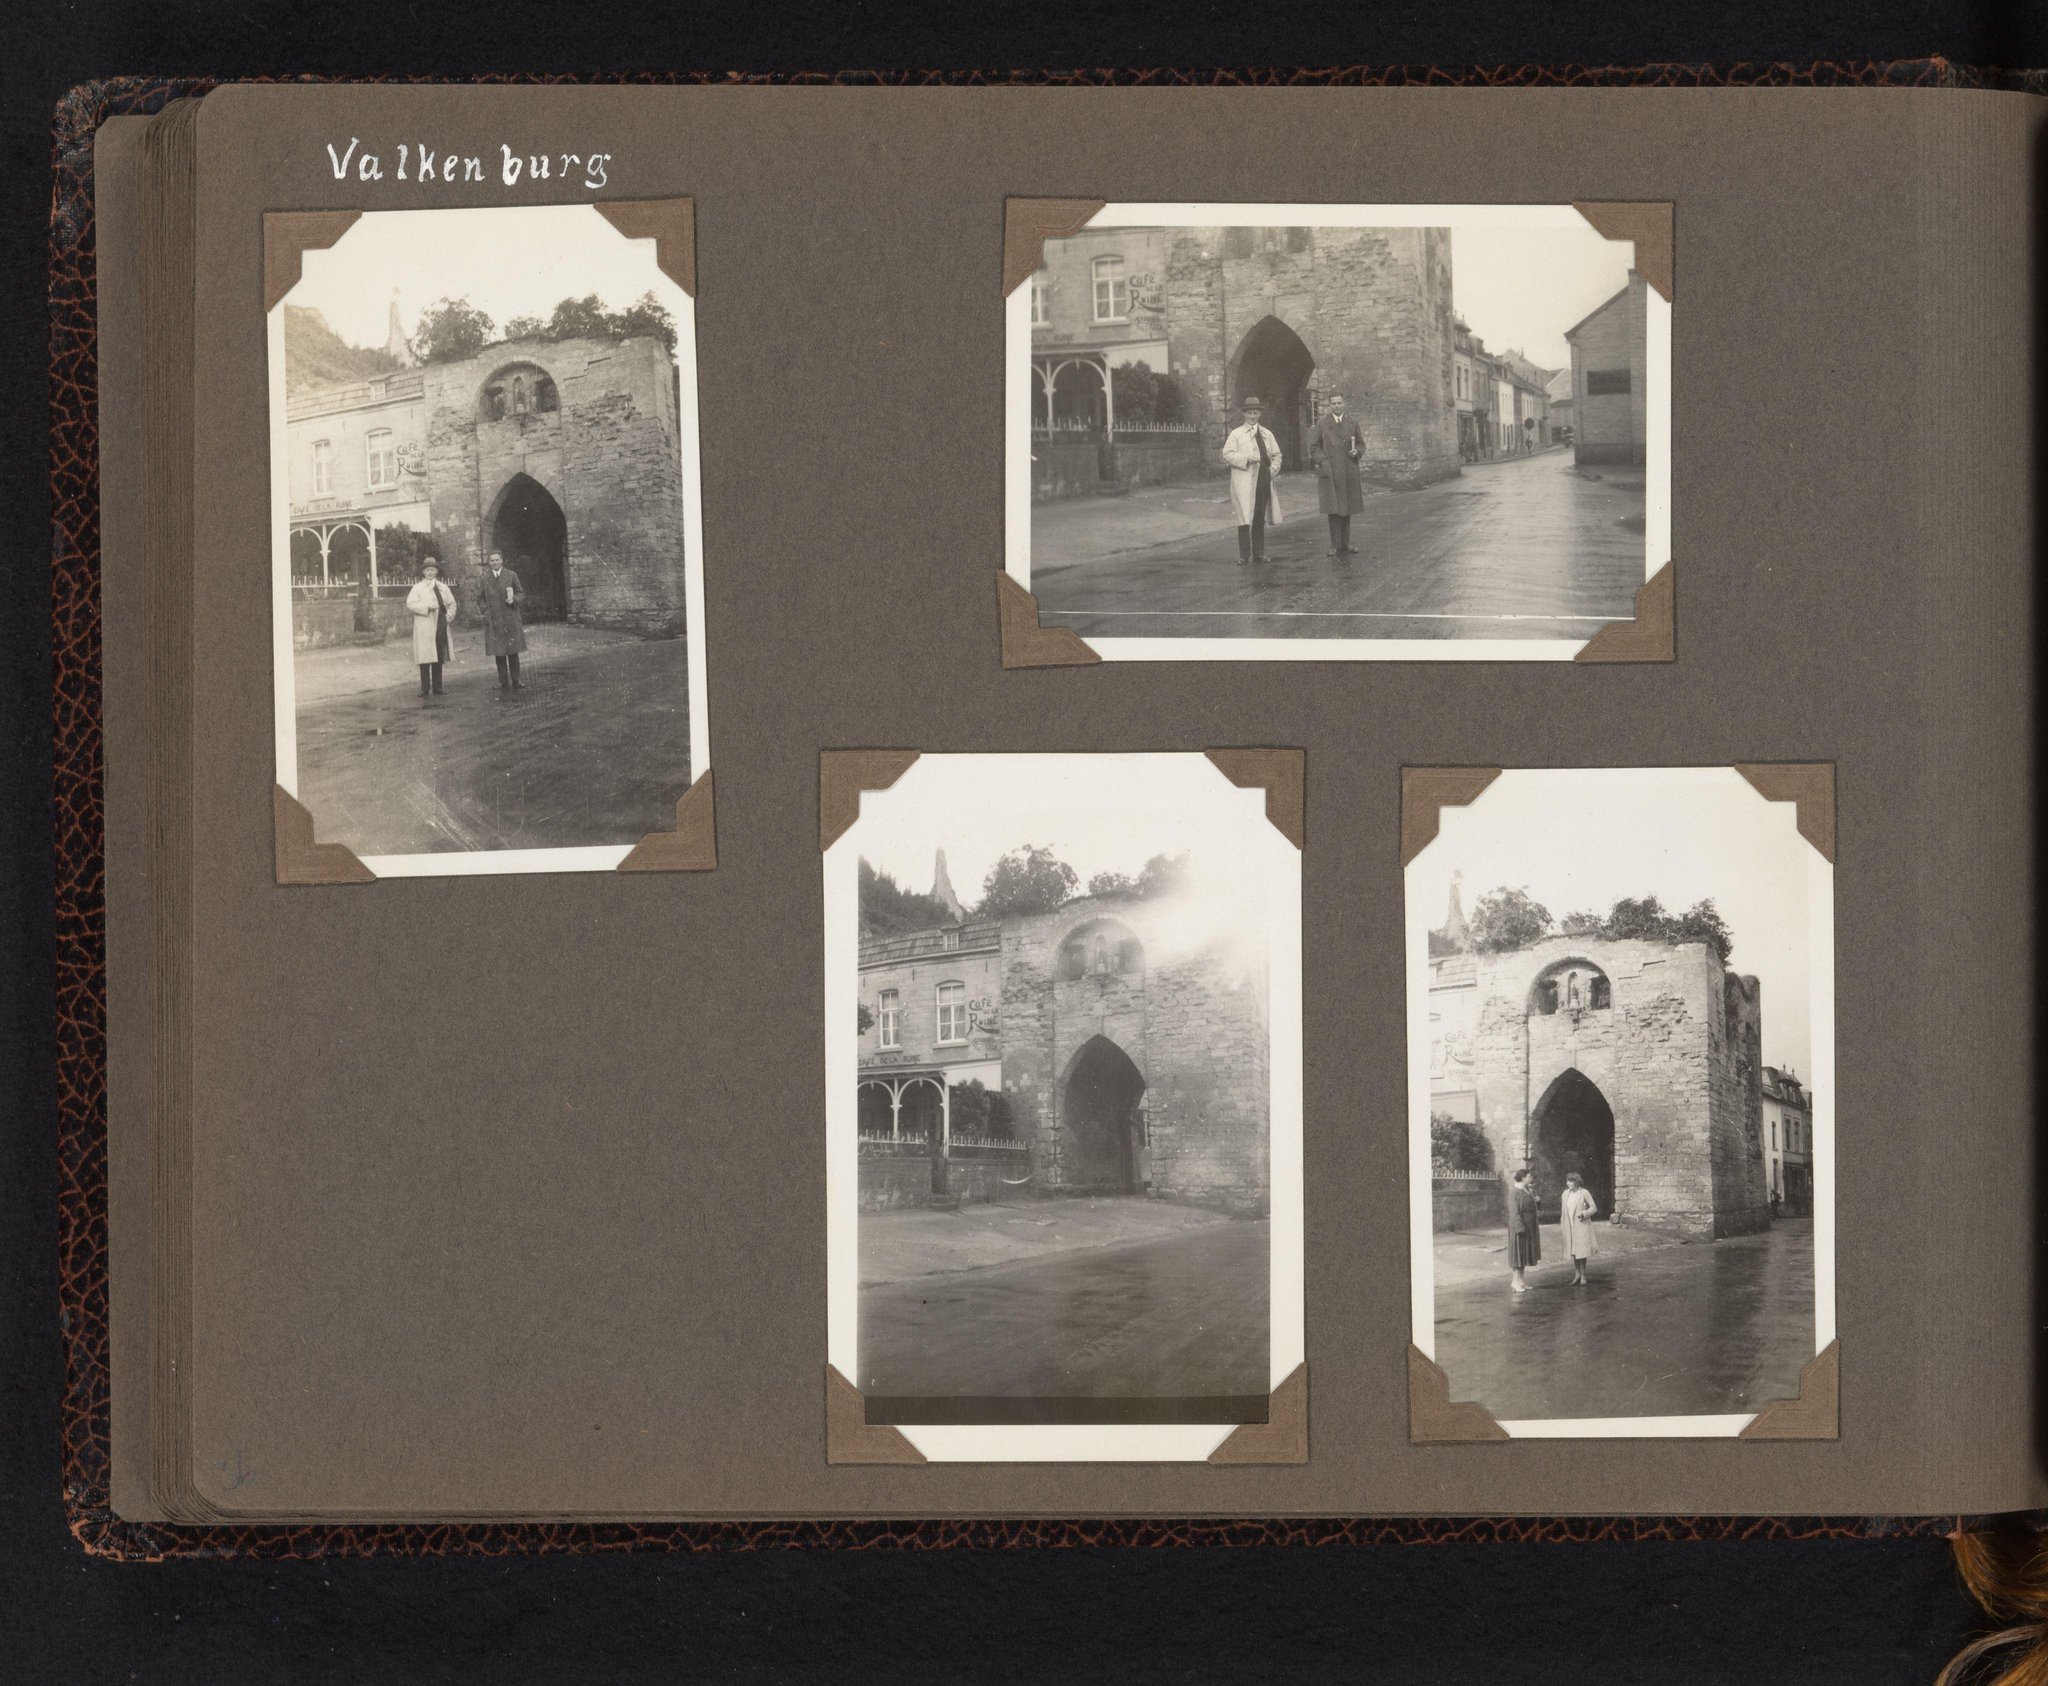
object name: album leaf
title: Echtpaar Berti Hoppe en Herman Besselaar met kennissen bij een oude stadspoort te Valkenburg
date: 1930-1931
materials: cardboard, paper, photographic support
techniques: gelatin silver print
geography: valkenburg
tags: city-gate (+ city(-scape) with figures, staffage)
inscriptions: inscription: ‘Valkenburg’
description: Vier foto's gemaakt tijdens hun vakantie in Nederland. Deze pagina maakt deel uit van een album.